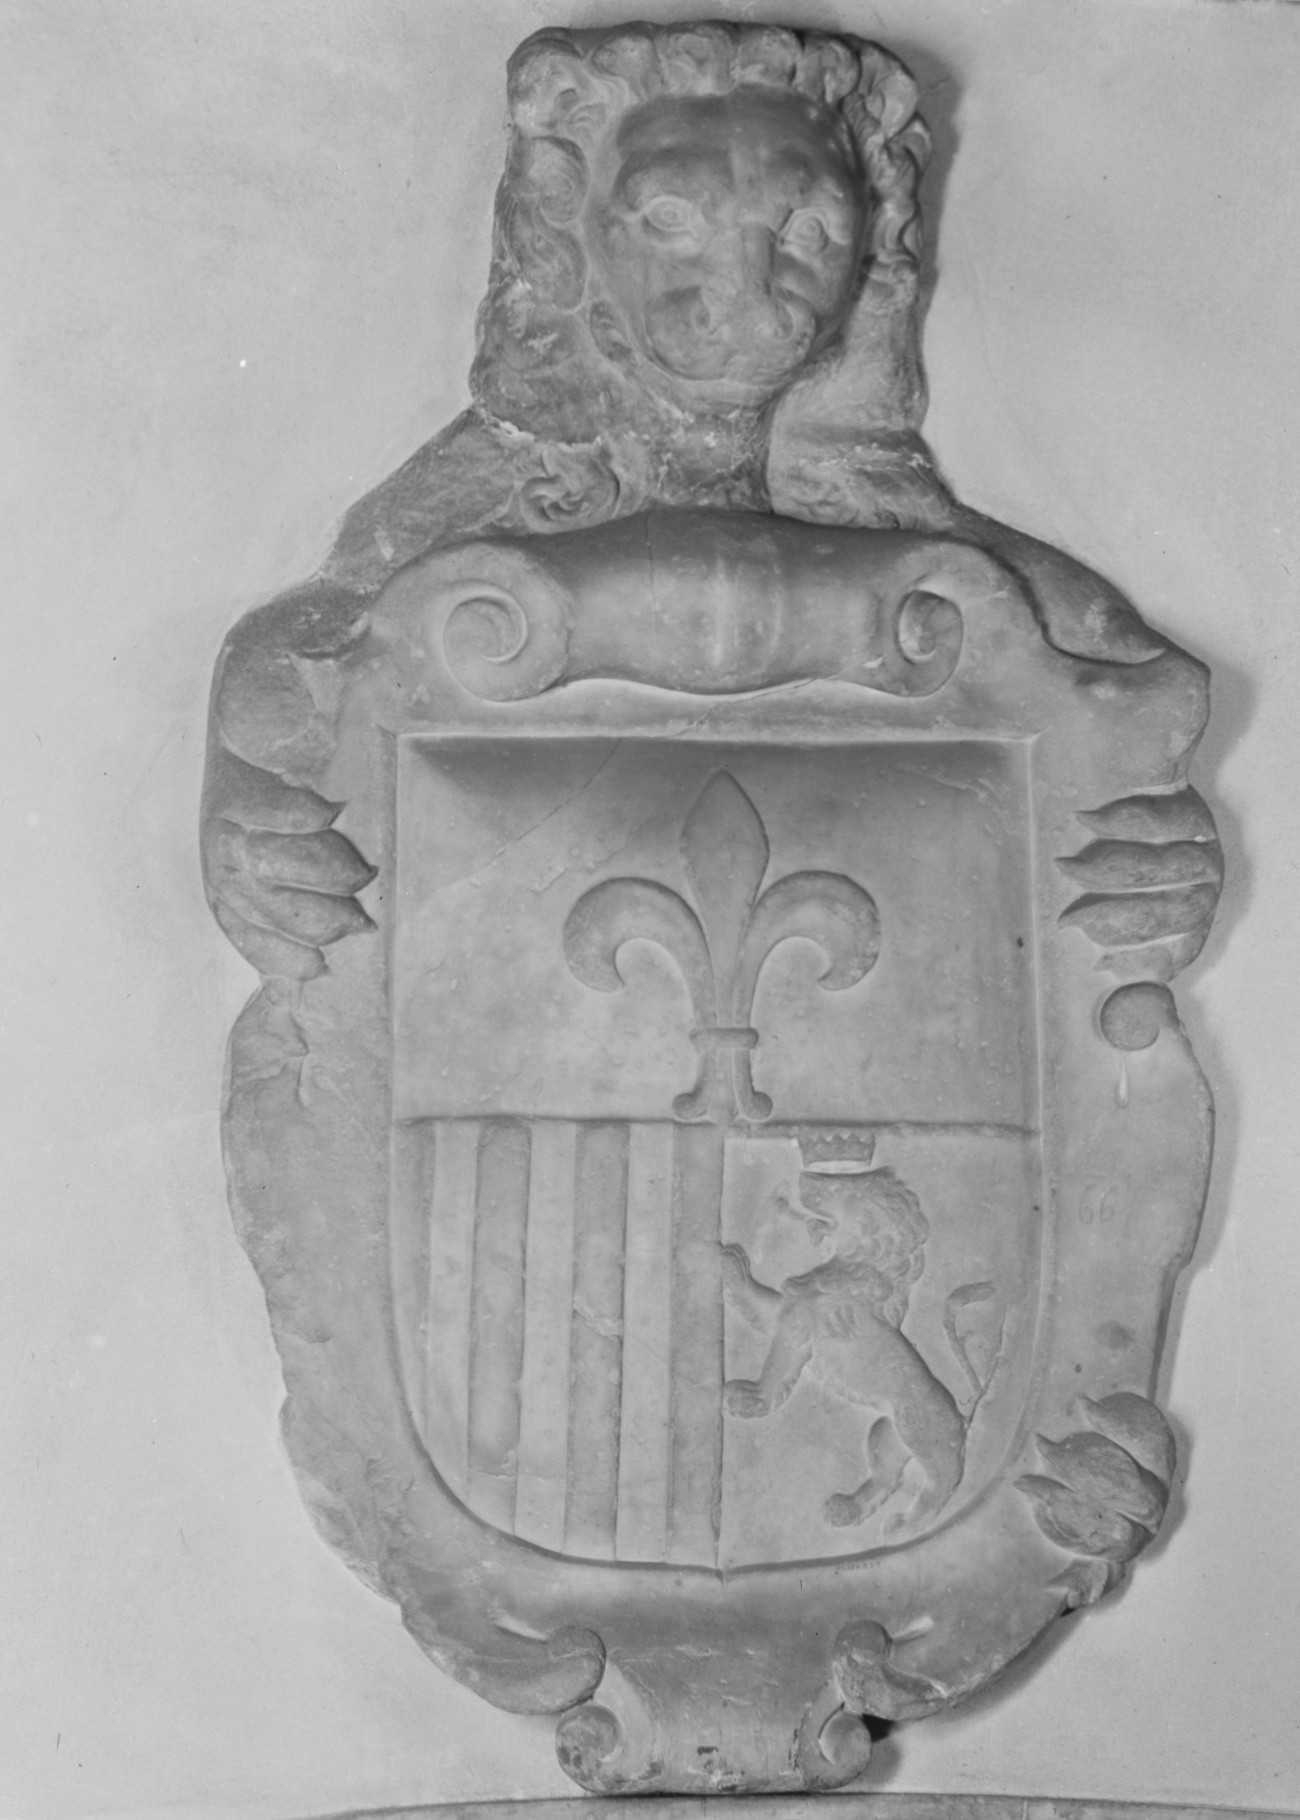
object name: armorial shield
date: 1520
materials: marble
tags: shields,coat of arms